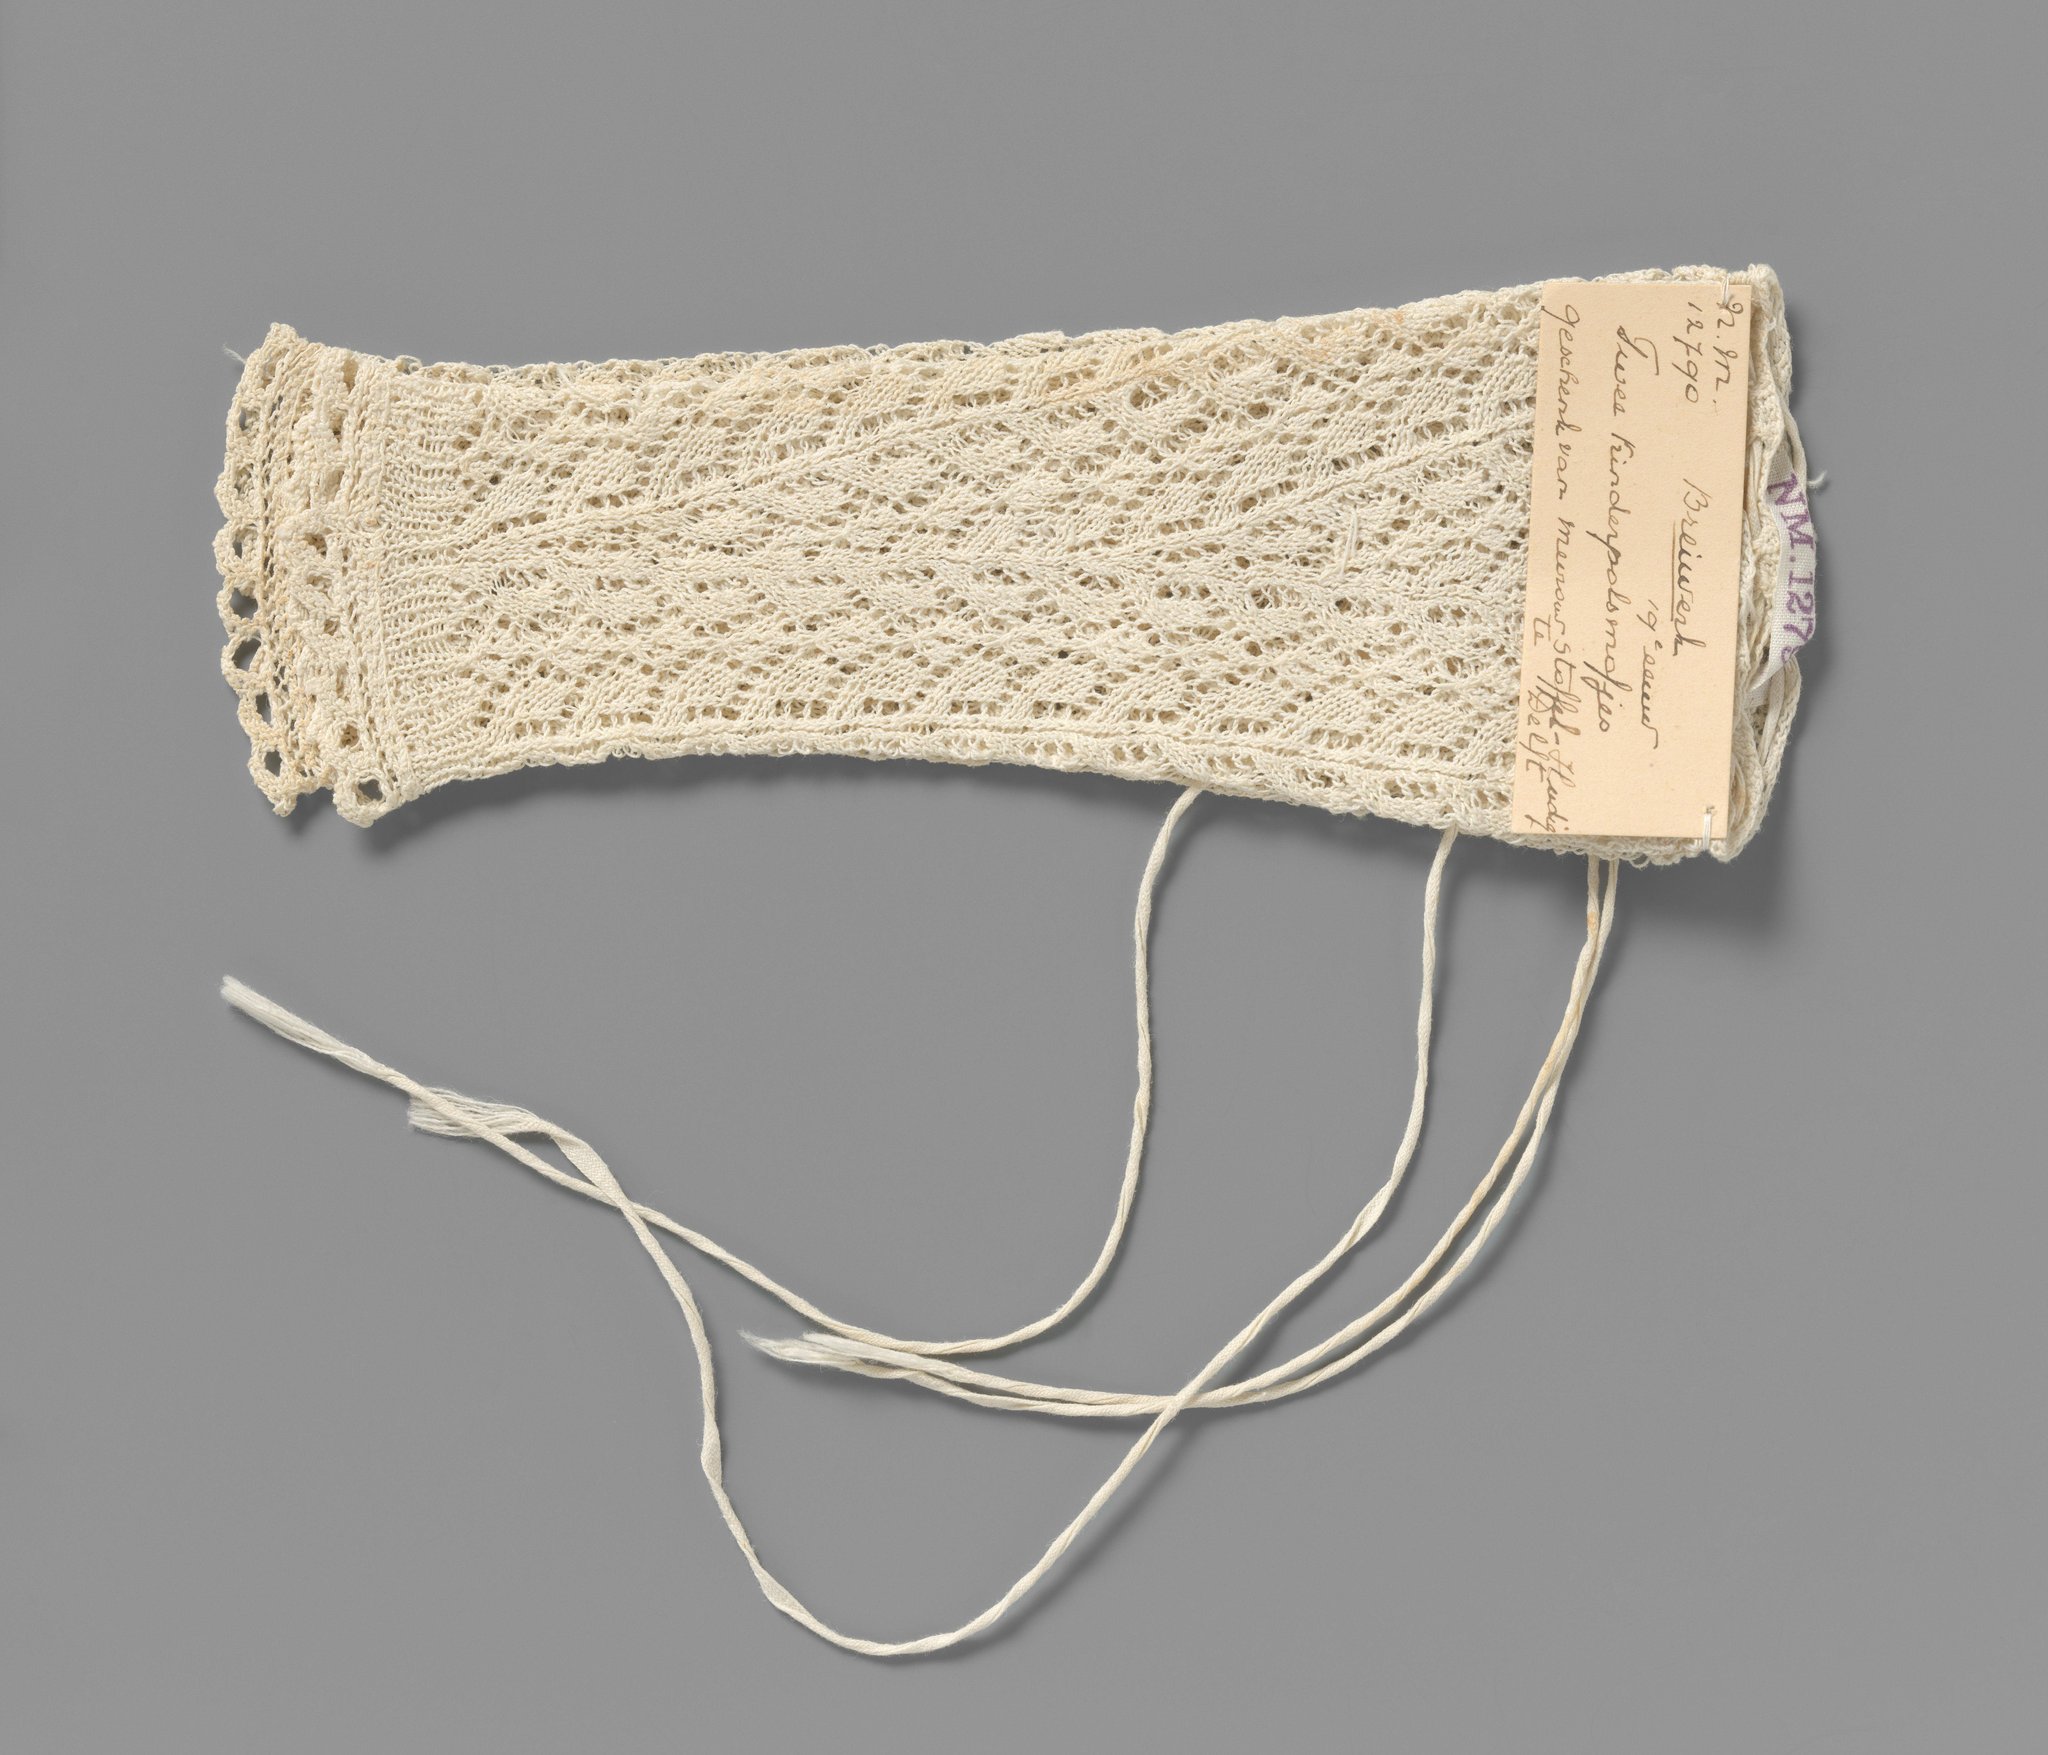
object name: childrenswear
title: Mitaine van witte katoen in ajour breiwerk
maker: Anonymous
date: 1800-1900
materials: cotton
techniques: embroidery, knitting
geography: netherlands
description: Mitaine van witte katoen in ajour breiwerk met geschulpte afzet rand en rijglint voor een baby of kind.